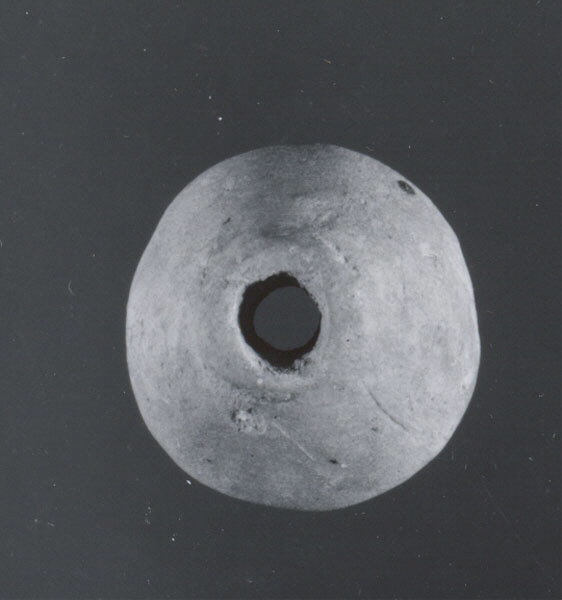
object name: whorl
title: Spindle whorl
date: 5000-4001 BCE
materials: ceramic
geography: iran